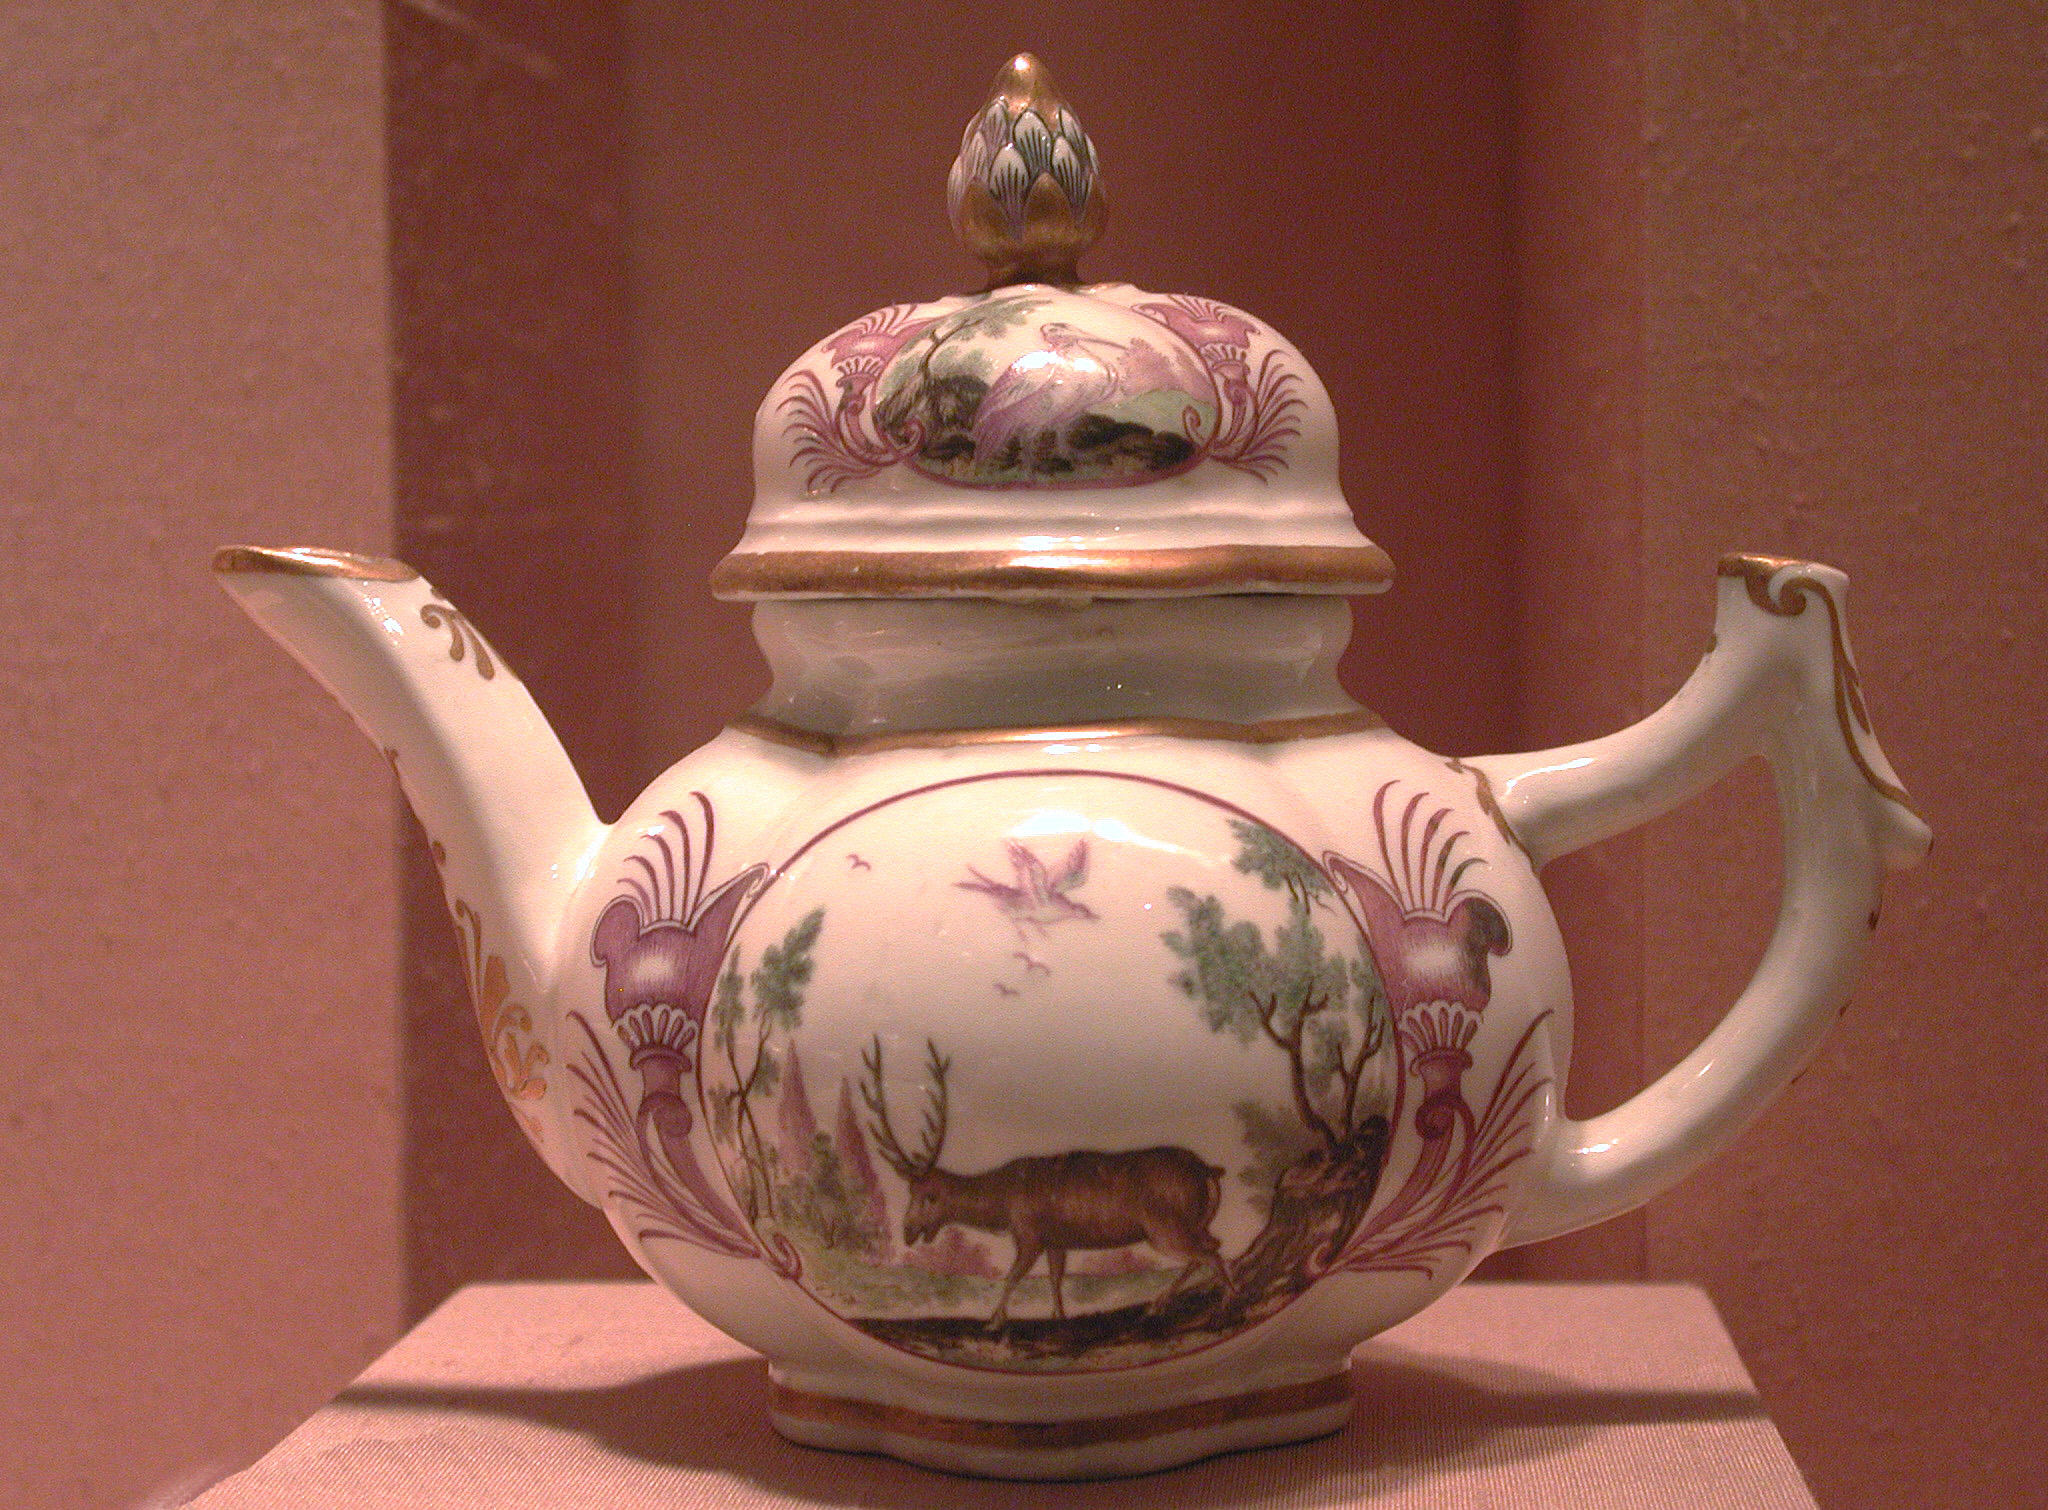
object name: teapot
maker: vienna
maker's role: manufactory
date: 1730-1740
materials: hard paste porcelain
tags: birds,deer,trees